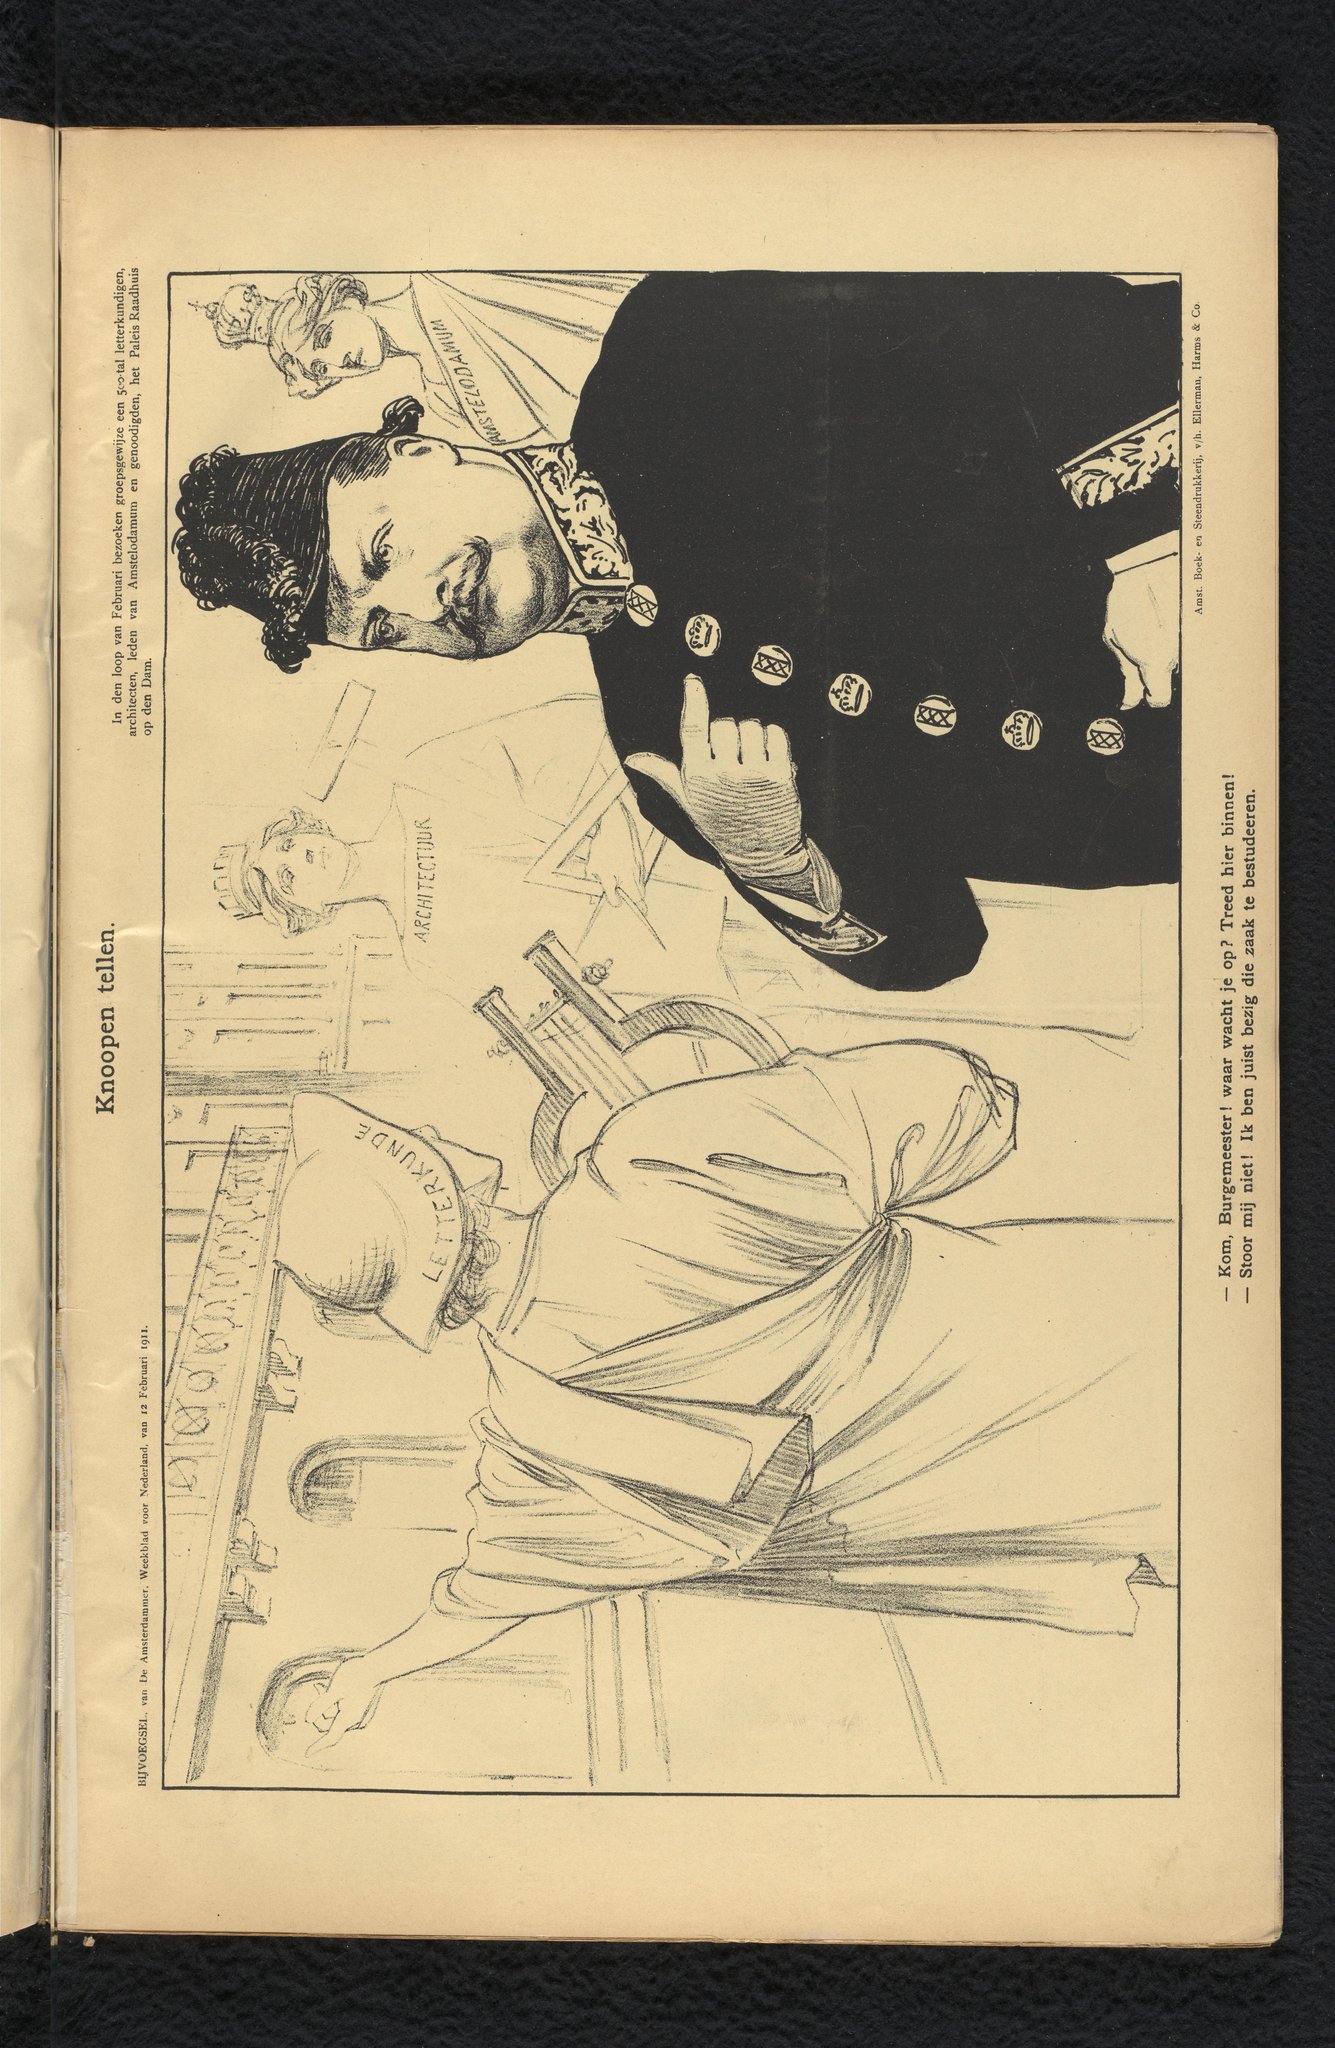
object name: cartoon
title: Knoopen tellen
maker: johan braakensiek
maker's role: draughtsman, print maker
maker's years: 1858-1940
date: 1911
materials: paper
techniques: lithograph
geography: netherlands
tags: the hague, haarlem, mayor, antonie röell, personification of a city, town-patron(ess), mayor, burgomaster, literature ~ arts, 'architectura', symbolic representations, allegories and emblems ~ architecture; 'architettura' (ripa), political caricatures and satires, royal palace of amsterdam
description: De Letterkunde nodigt de Amsterdamse burgemeester Antonie Röell uit het Paleis op de Dam te bezoeken. Architectuur en de Amsterdamse stedemaagd zien toe.